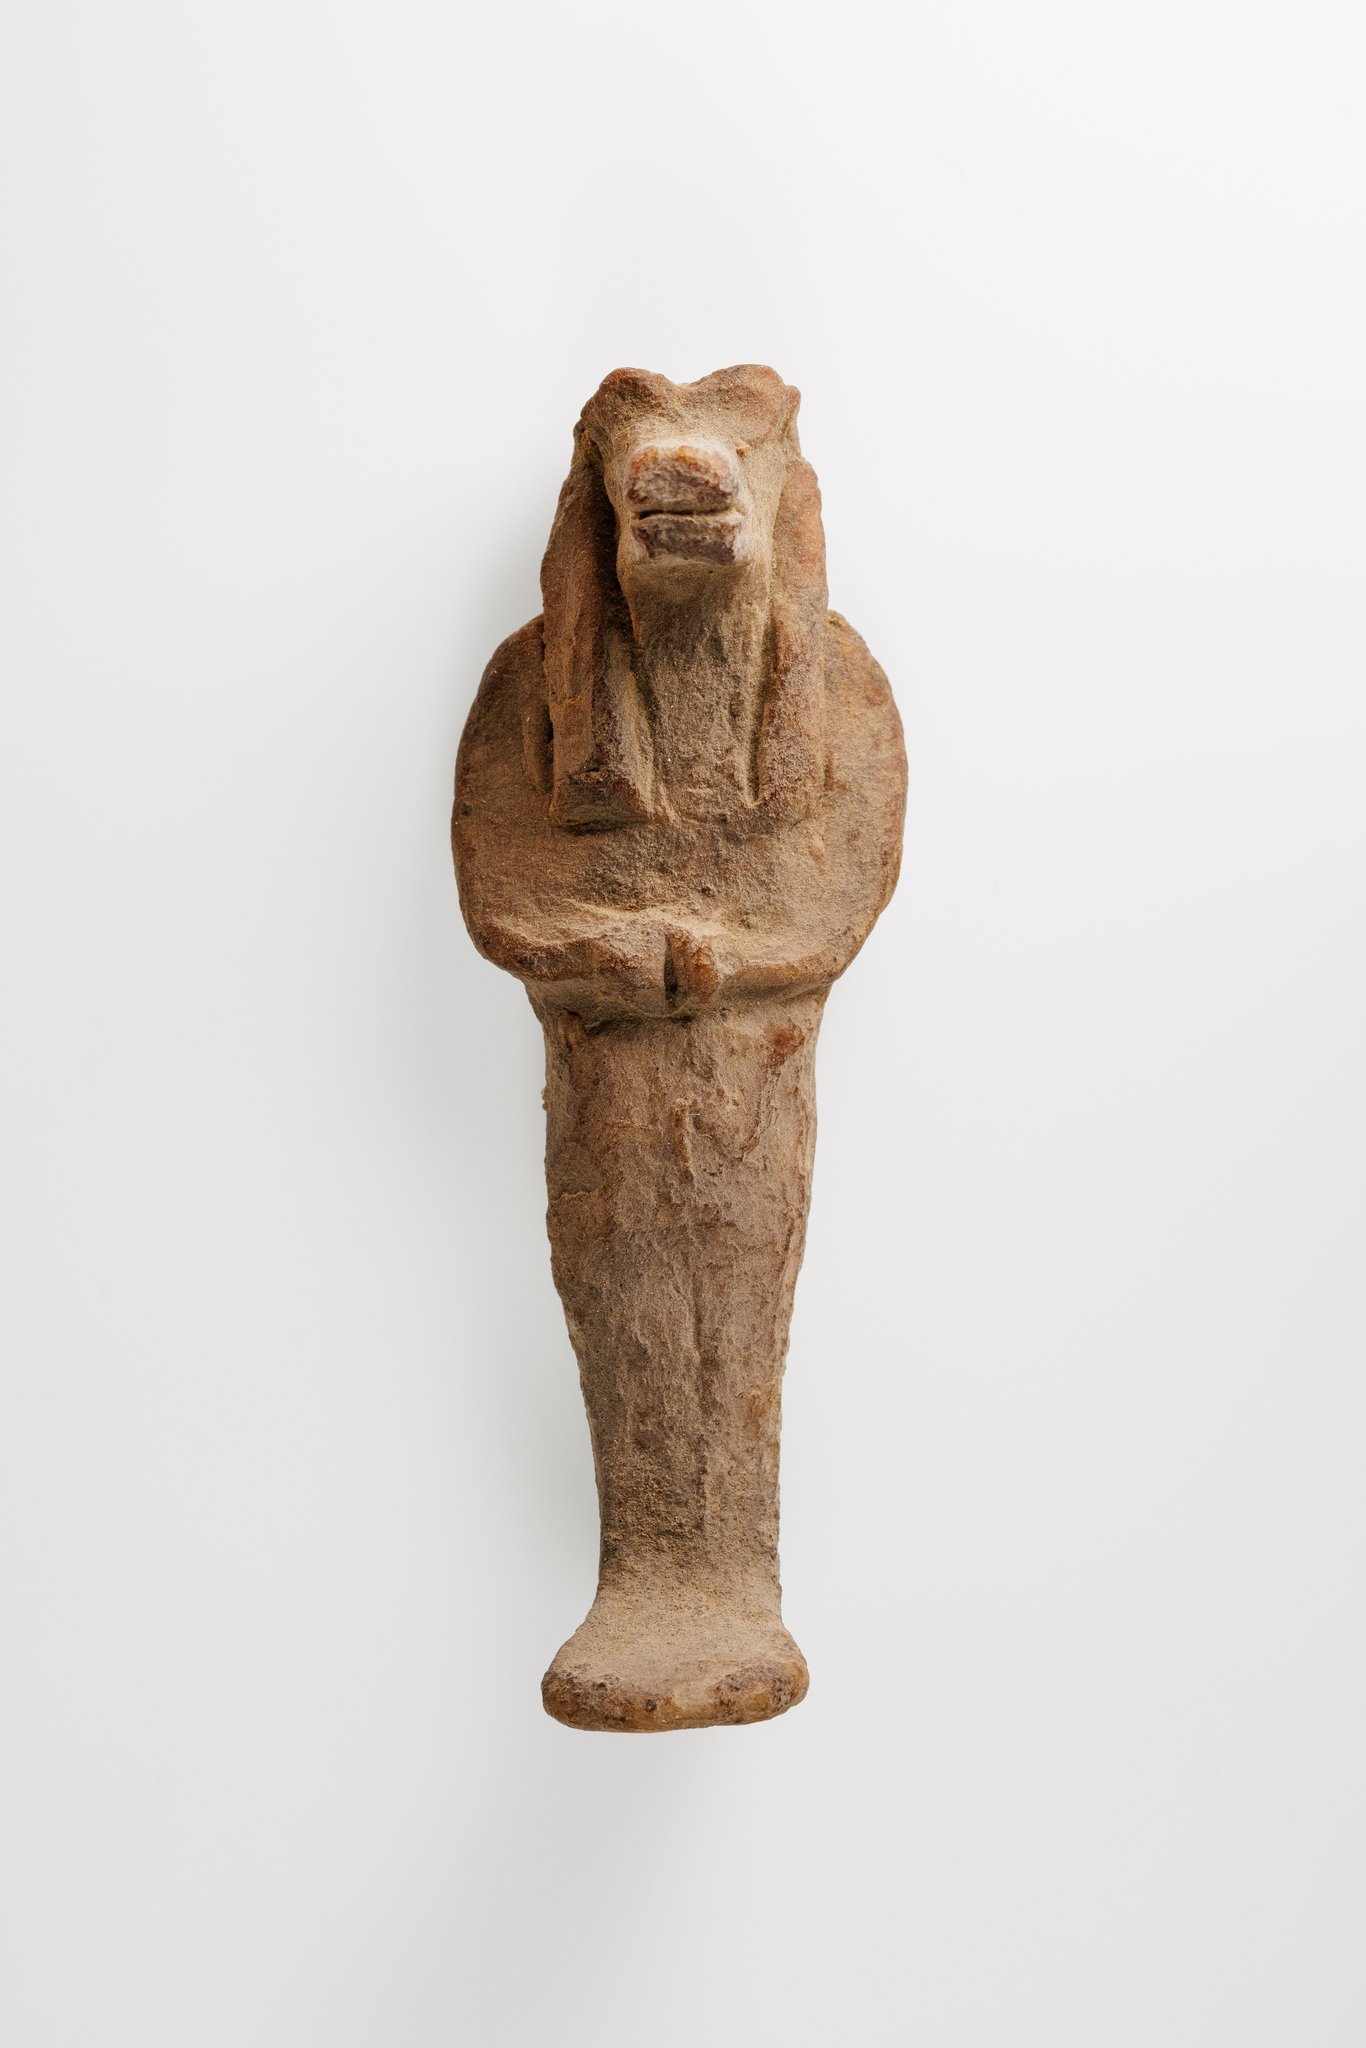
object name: four son of horus, hapy, baboon headed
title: Viscera figure with baboon head (Hapy)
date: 1000-945 BCE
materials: wax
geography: egypt